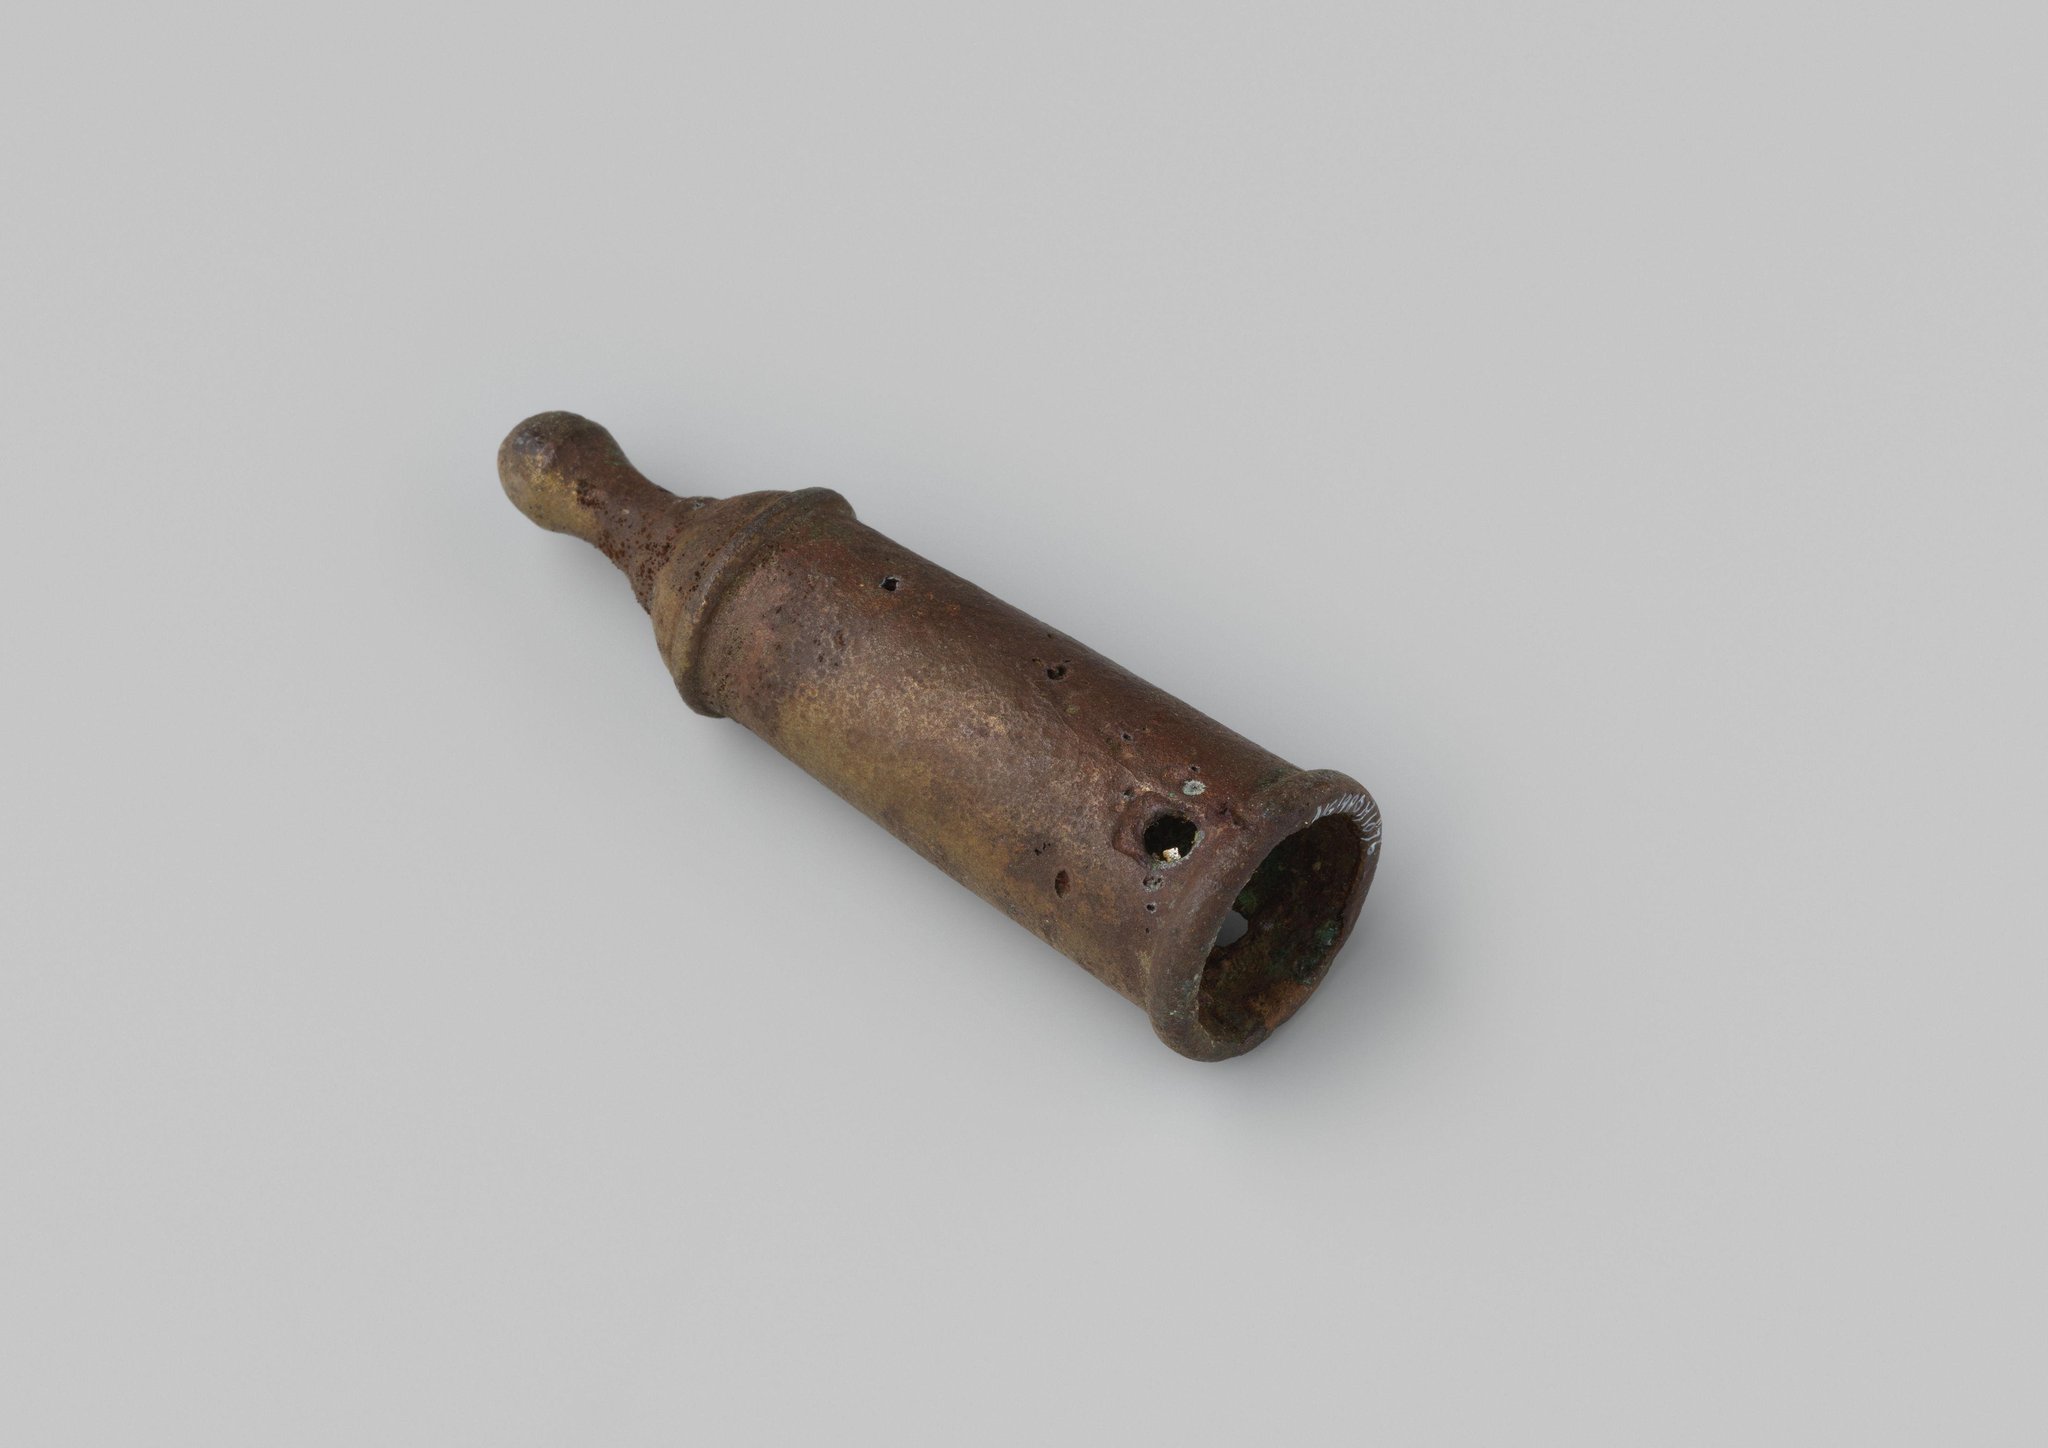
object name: clamp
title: Klem afkomstig uit het wrak van de Oost-Indiëvaarder Hollandia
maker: Anonymous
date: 1700-1743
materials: copper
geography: netherlands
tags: verenigde oostindische compagnie, hollandia (schip)